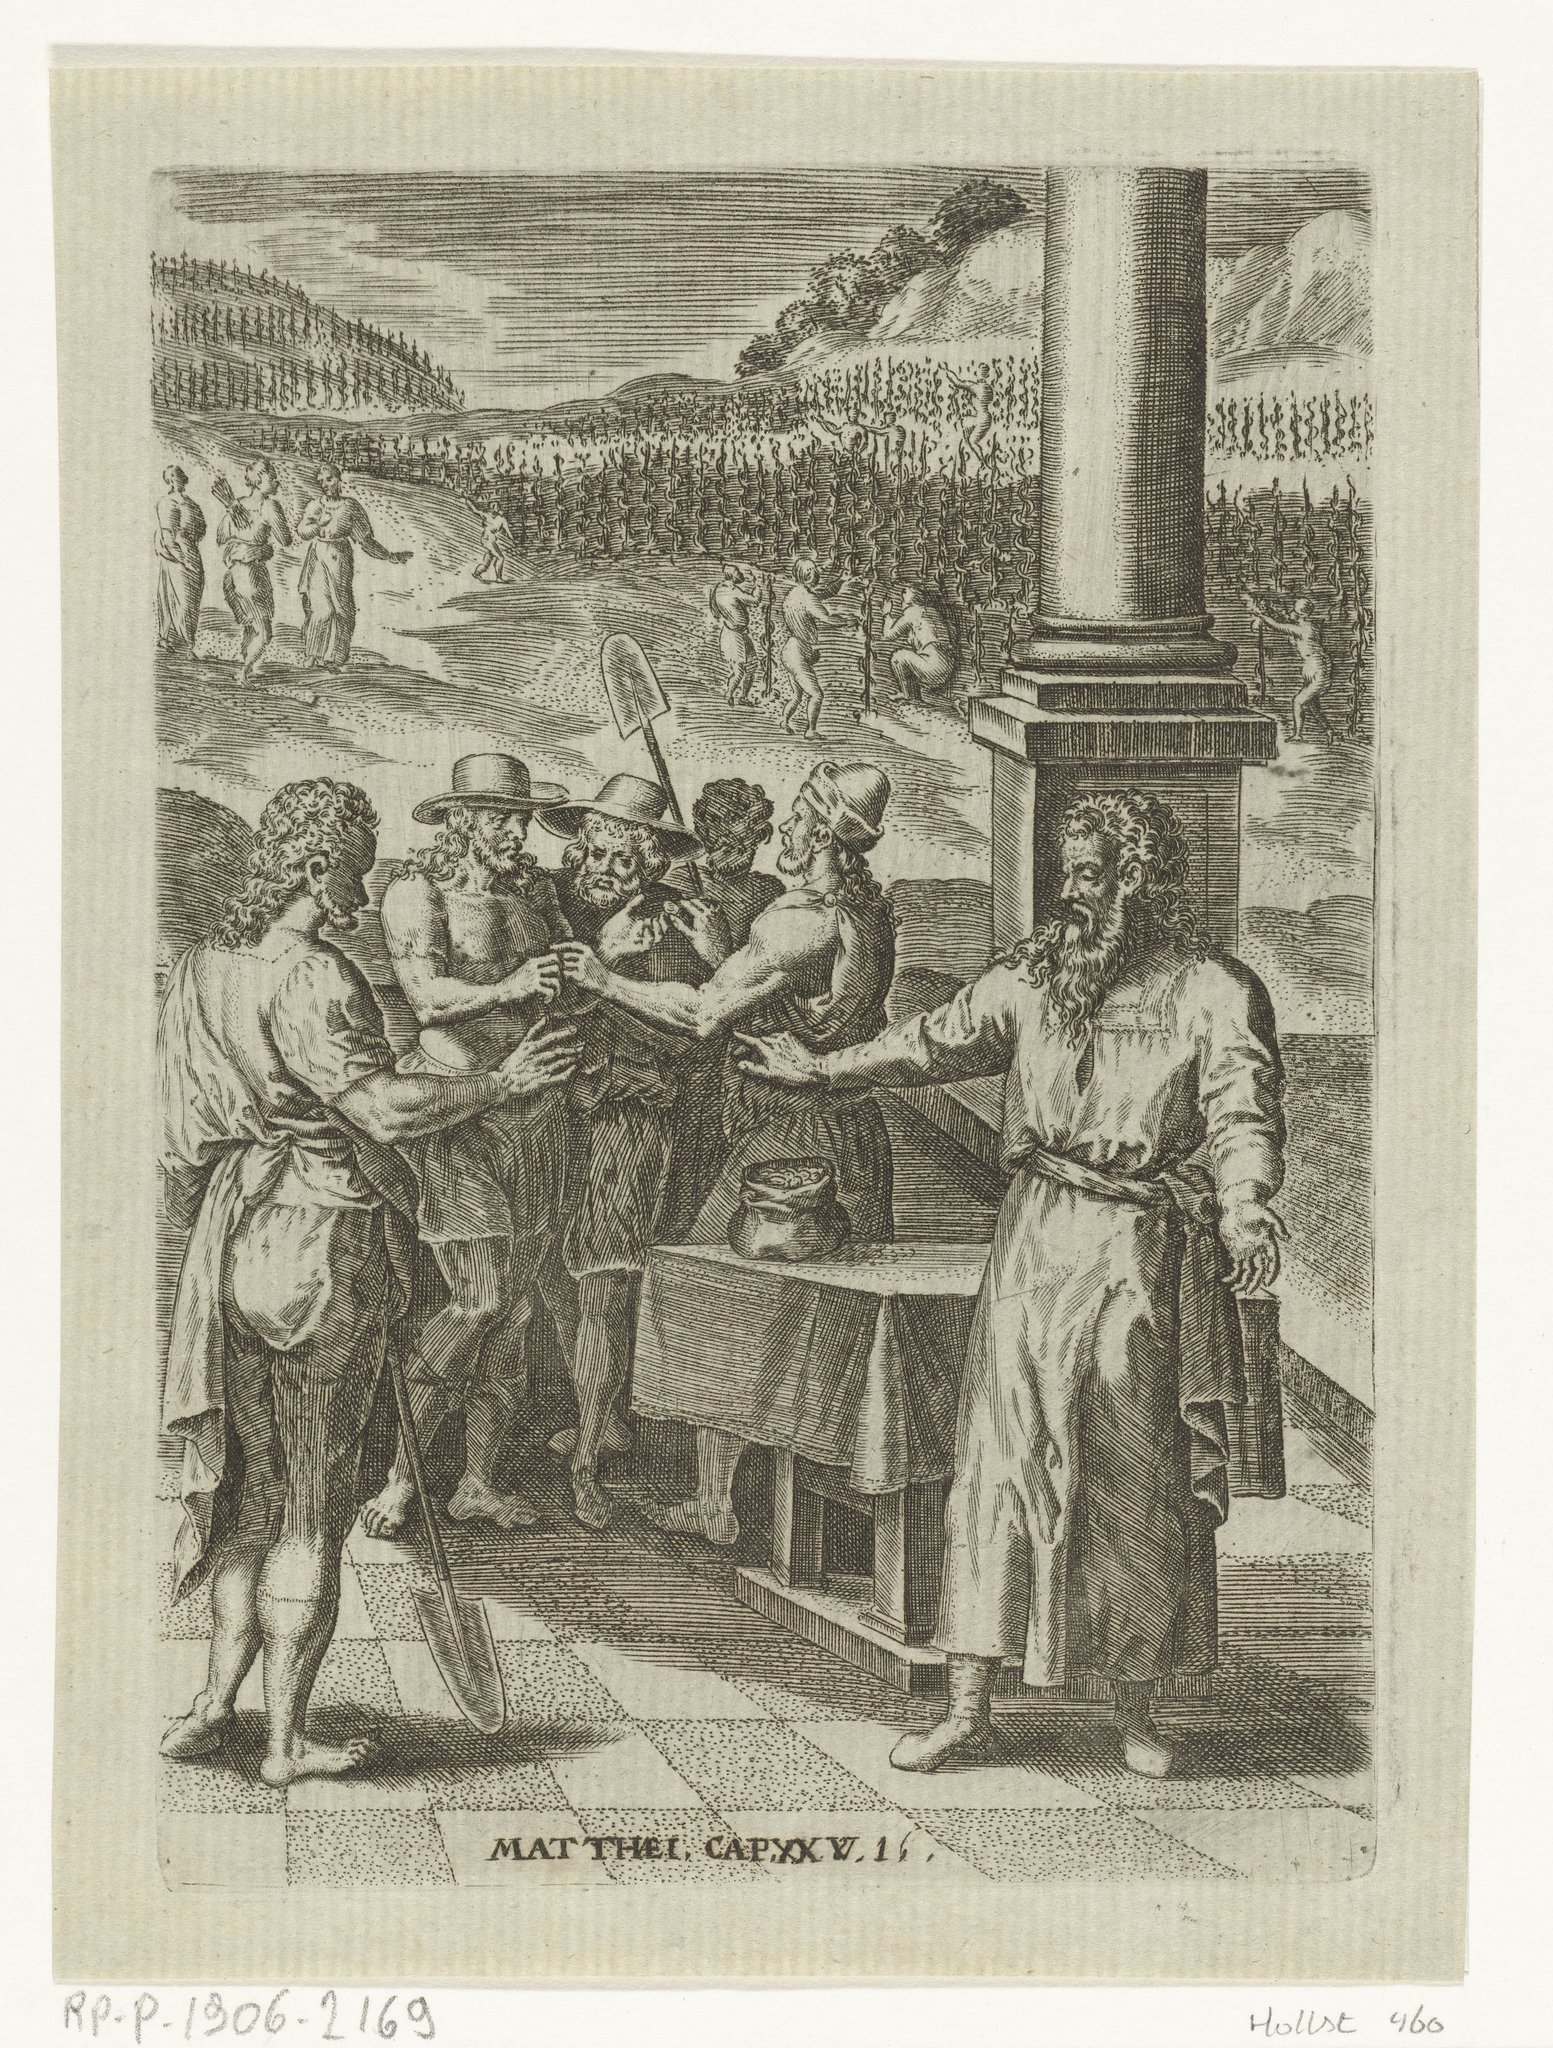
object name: print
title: Gelijkenis van de werkers in de wijngaard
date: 1583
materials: paper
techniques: engraving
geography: antwerp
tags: at the end of the day the lord pays all the labourers equally; those that worked all day object, the lord sends labourers to the vineyard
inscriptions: collector's mark: Lugt 2228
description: Boekillustratie bij parabel van de werkers in de wijngaard (Matteüs 20). Op de achtergrond worden arbeiders ingehuurd om te werken in de wijngaard. Op de voorgrond worden de arbeiders op het eind van de dag elk met een denarie betaald uit een buidel met goud. Enkele arbeiders protesteren omdat ze langer hebben gewerkt als de anderen, maar de landeigenaar is onverbiddelijk. De prent bevat een onderschrift met een verwijzing naar de bijhorende Bijbelpassage.